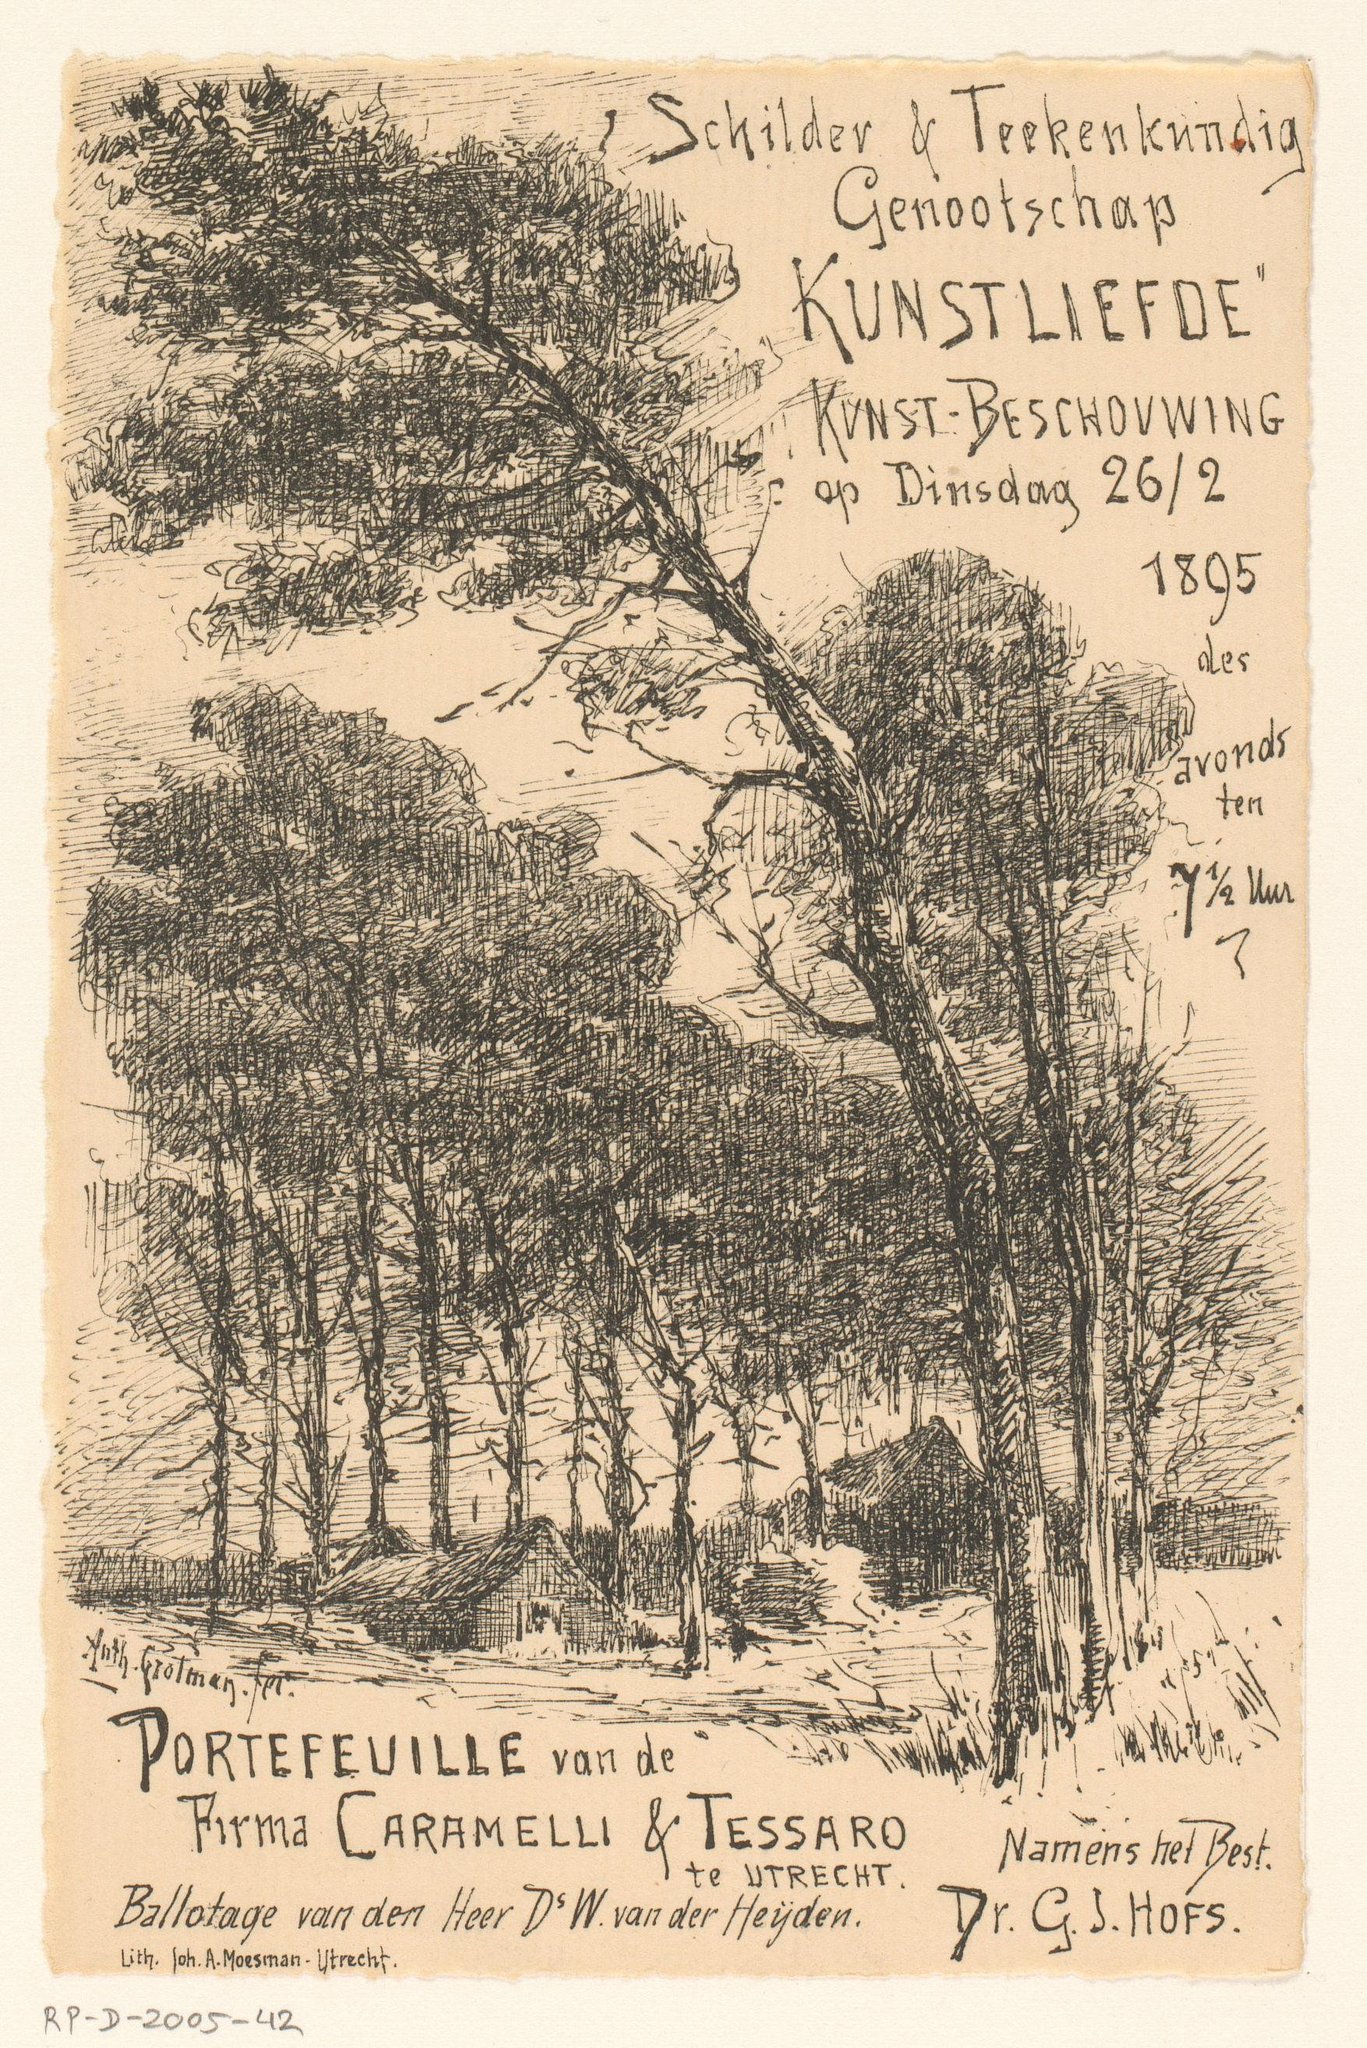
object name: invitation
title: Uitnodiging van Schilder- en Teekenkundig Genootschap "Kunstliefde" voor een kunstbeschouwing, 26 februari 1895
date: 1801-1895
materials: paper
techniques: lithograph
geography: utrecht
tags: criticizing and discussing art, art criticism, circle, club of artists, collecting and exhibiting products of the fine arts, forest, wood, farm or solitary house in landscape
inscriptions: collector's mark: Lugt 2228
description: Huizen onder hoge bomen. Uitnodiging van Schilder- en Teekenkundig Genootschap "Kunstliefde" voor een kunstbeschouwing op 26 februari 1895 van de portefeuille van de firma Caramelli & Tessaro te Utrecht.